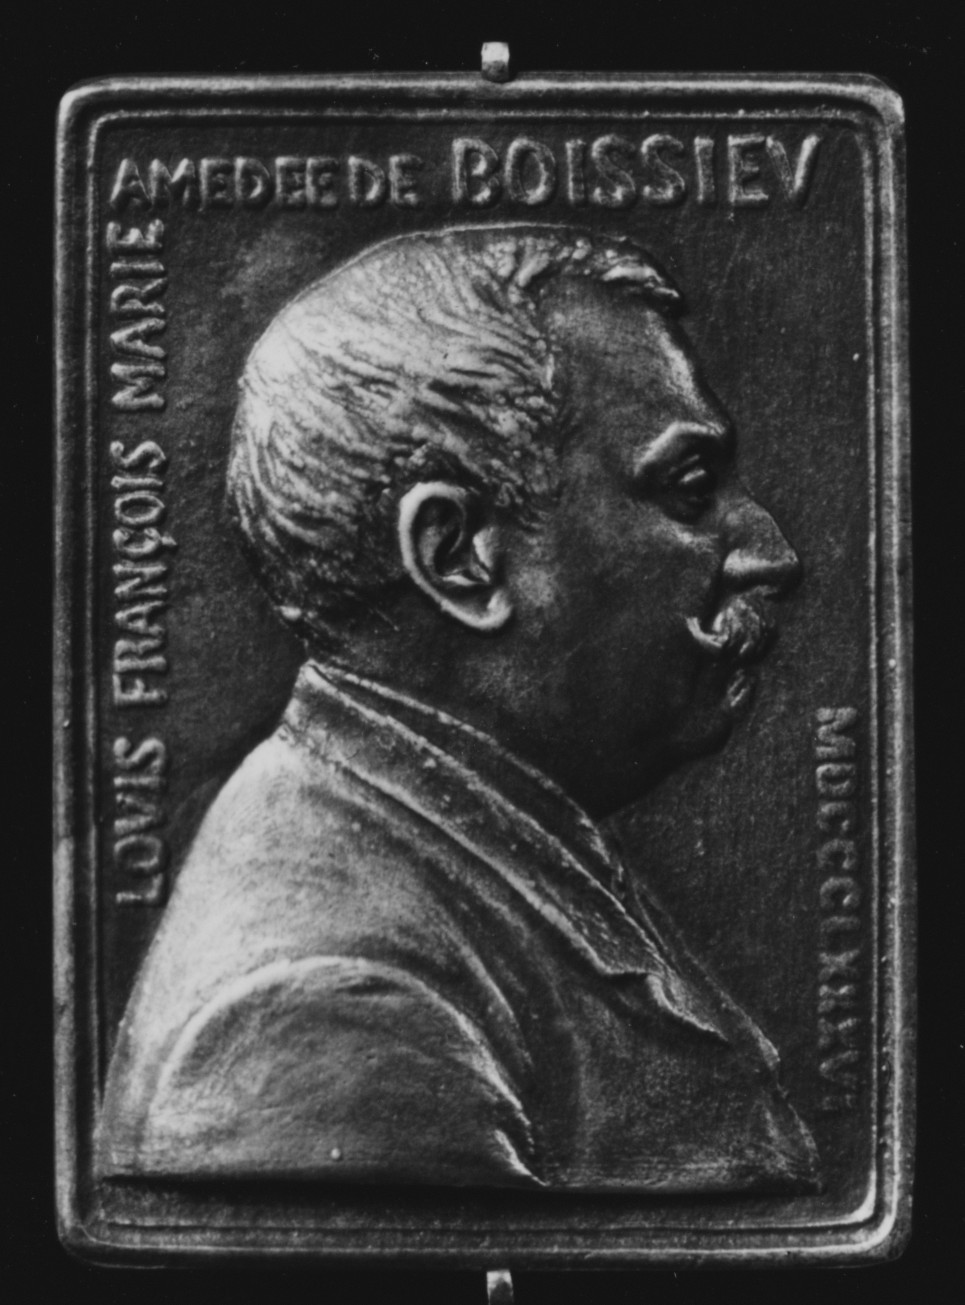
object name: plaquette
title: M. de Boissieu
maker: louis-oscar roty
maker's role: artist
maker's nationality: french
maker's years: 1846-1911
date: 1886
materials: bronze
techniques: casting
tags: men,profiles